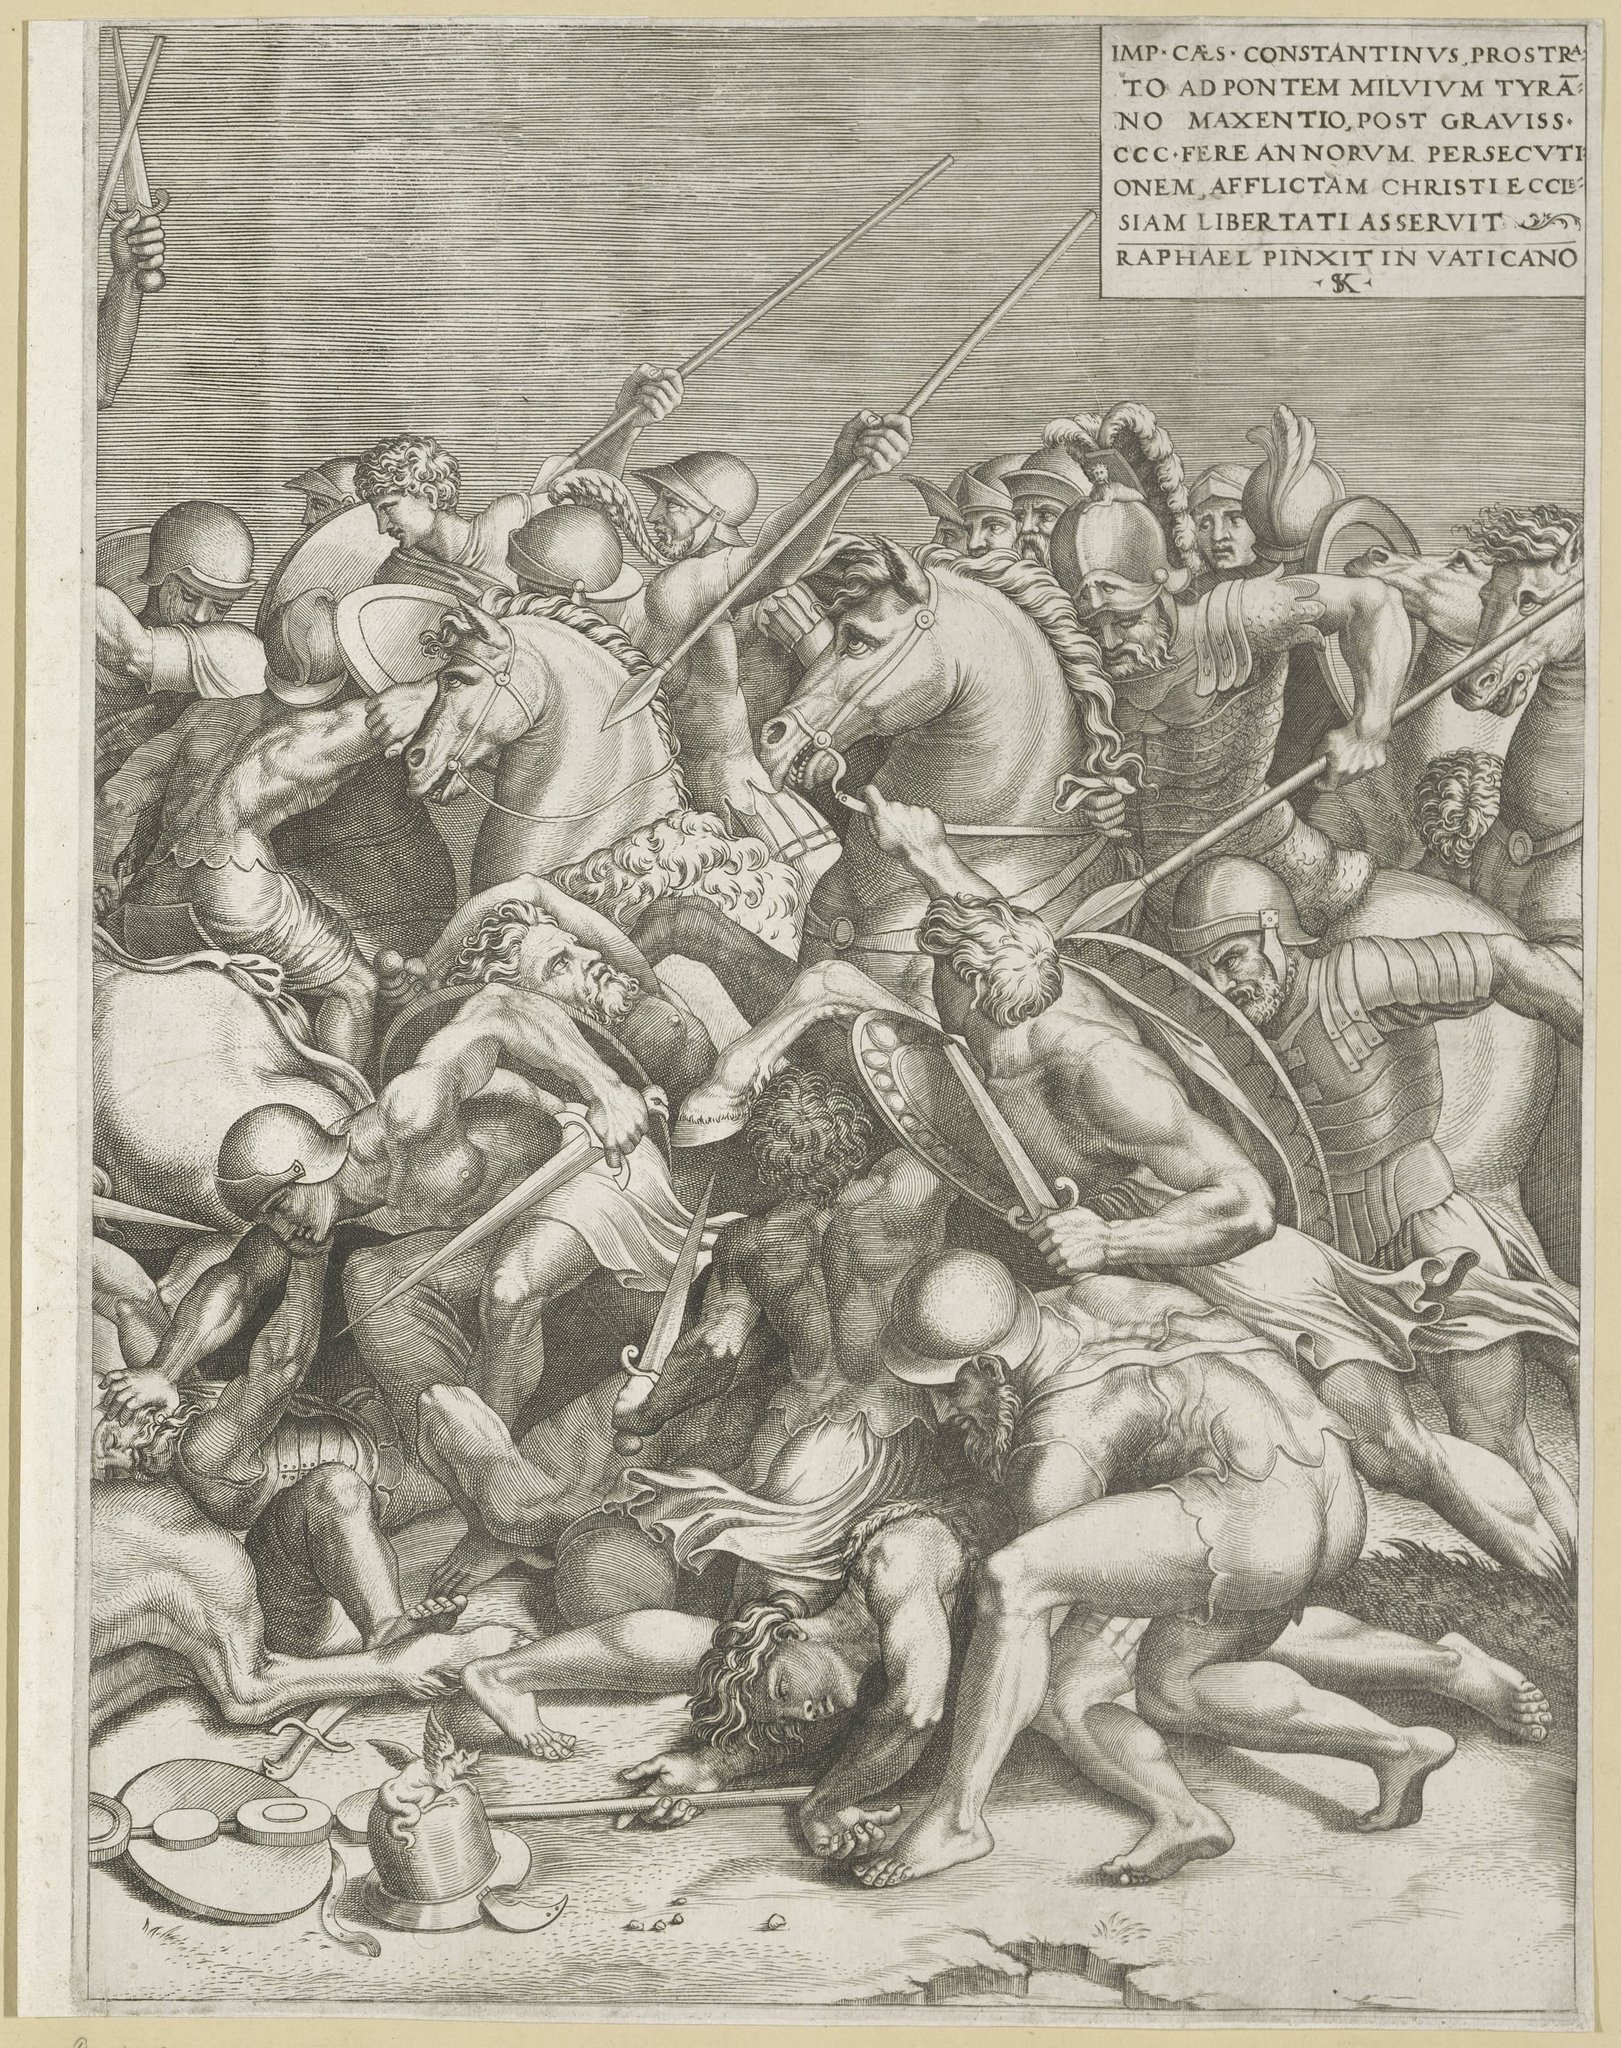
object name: print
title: Slag bij de Milvische brug (rechter blad)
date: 1500-1599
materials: paper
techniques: engraving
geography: vatican city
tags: the battle of the milvian bridge (saxa rubra): st. constantine on horseback confronts maxentius; a cross appears in the sky with in fiery letters 'in hoc signo vinces' (the raised standards of the roman soldiers carry a cross or the chi-rho monogram), warfare; military affairs (+ cavalry, horsemen), the soldier; the soldier's life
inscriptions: collector's mark: Lugt 11, collector's mark: Lugt 10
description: Gevechtsscène in een landschap: slag bij de Milvische brug. De soldaten van Constantijn in gevecht met de soldaten van Maxentius. Dode lichamen liggen op de grond. Soldaten te paard verdrinken in de rivier.